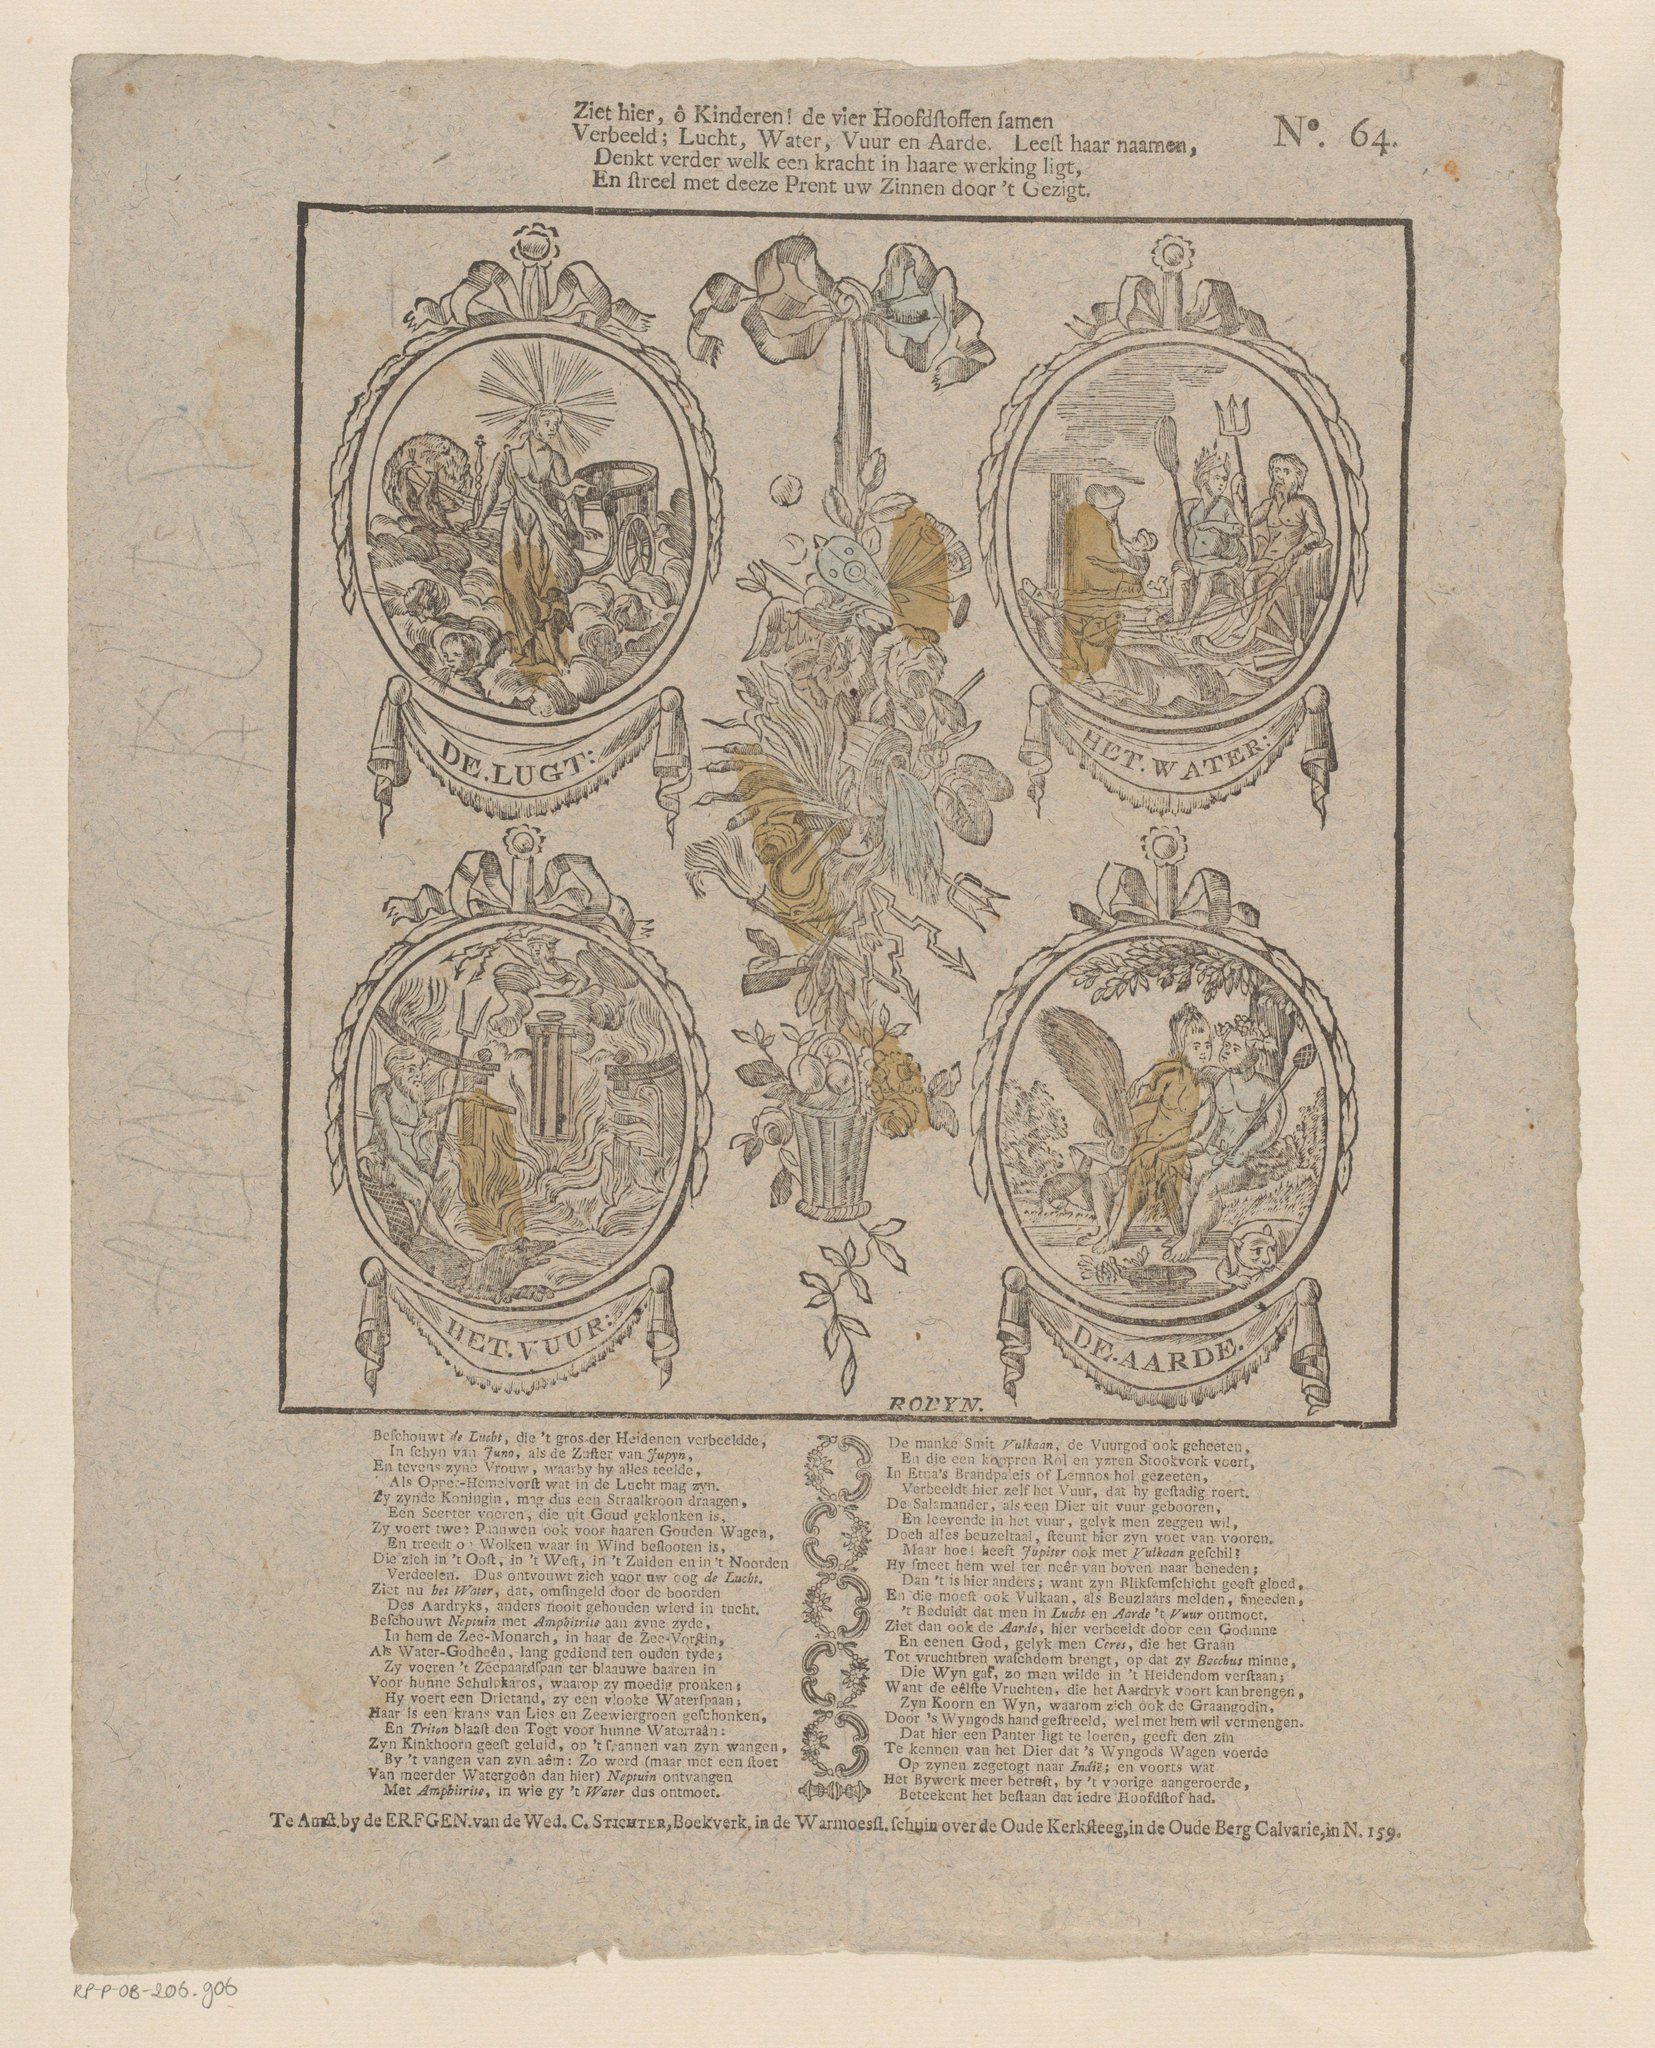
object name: print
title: Ziet hier, ô kinderen! de vier hoofdstoffen samen / Verbeeld; lucht, water, vuur en aarde / Leest haar naamen, / Denkt verder welk een kracht in haare werking ligt, / En streel met deeze prent uw zinnen door 't gezigt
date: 1715-1813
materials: paper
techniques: colour, letterpress printing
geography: amsterdam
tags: earth (one of the four elements), the four elements, and ether, the fifth element, water (one of the four elements), fire (one of the four elements), air (one of the four elements)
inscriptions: collector's mark: Lugt 2760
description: Vier medaillons met voorstellingen van de vier elementen. Tussen de medaillons een trofee met bloemen, vruchten, wapens en muziekinstrumenten. In de ondermarge een vers in twee kolommen. Genummerd rechtsboven: No. 64.